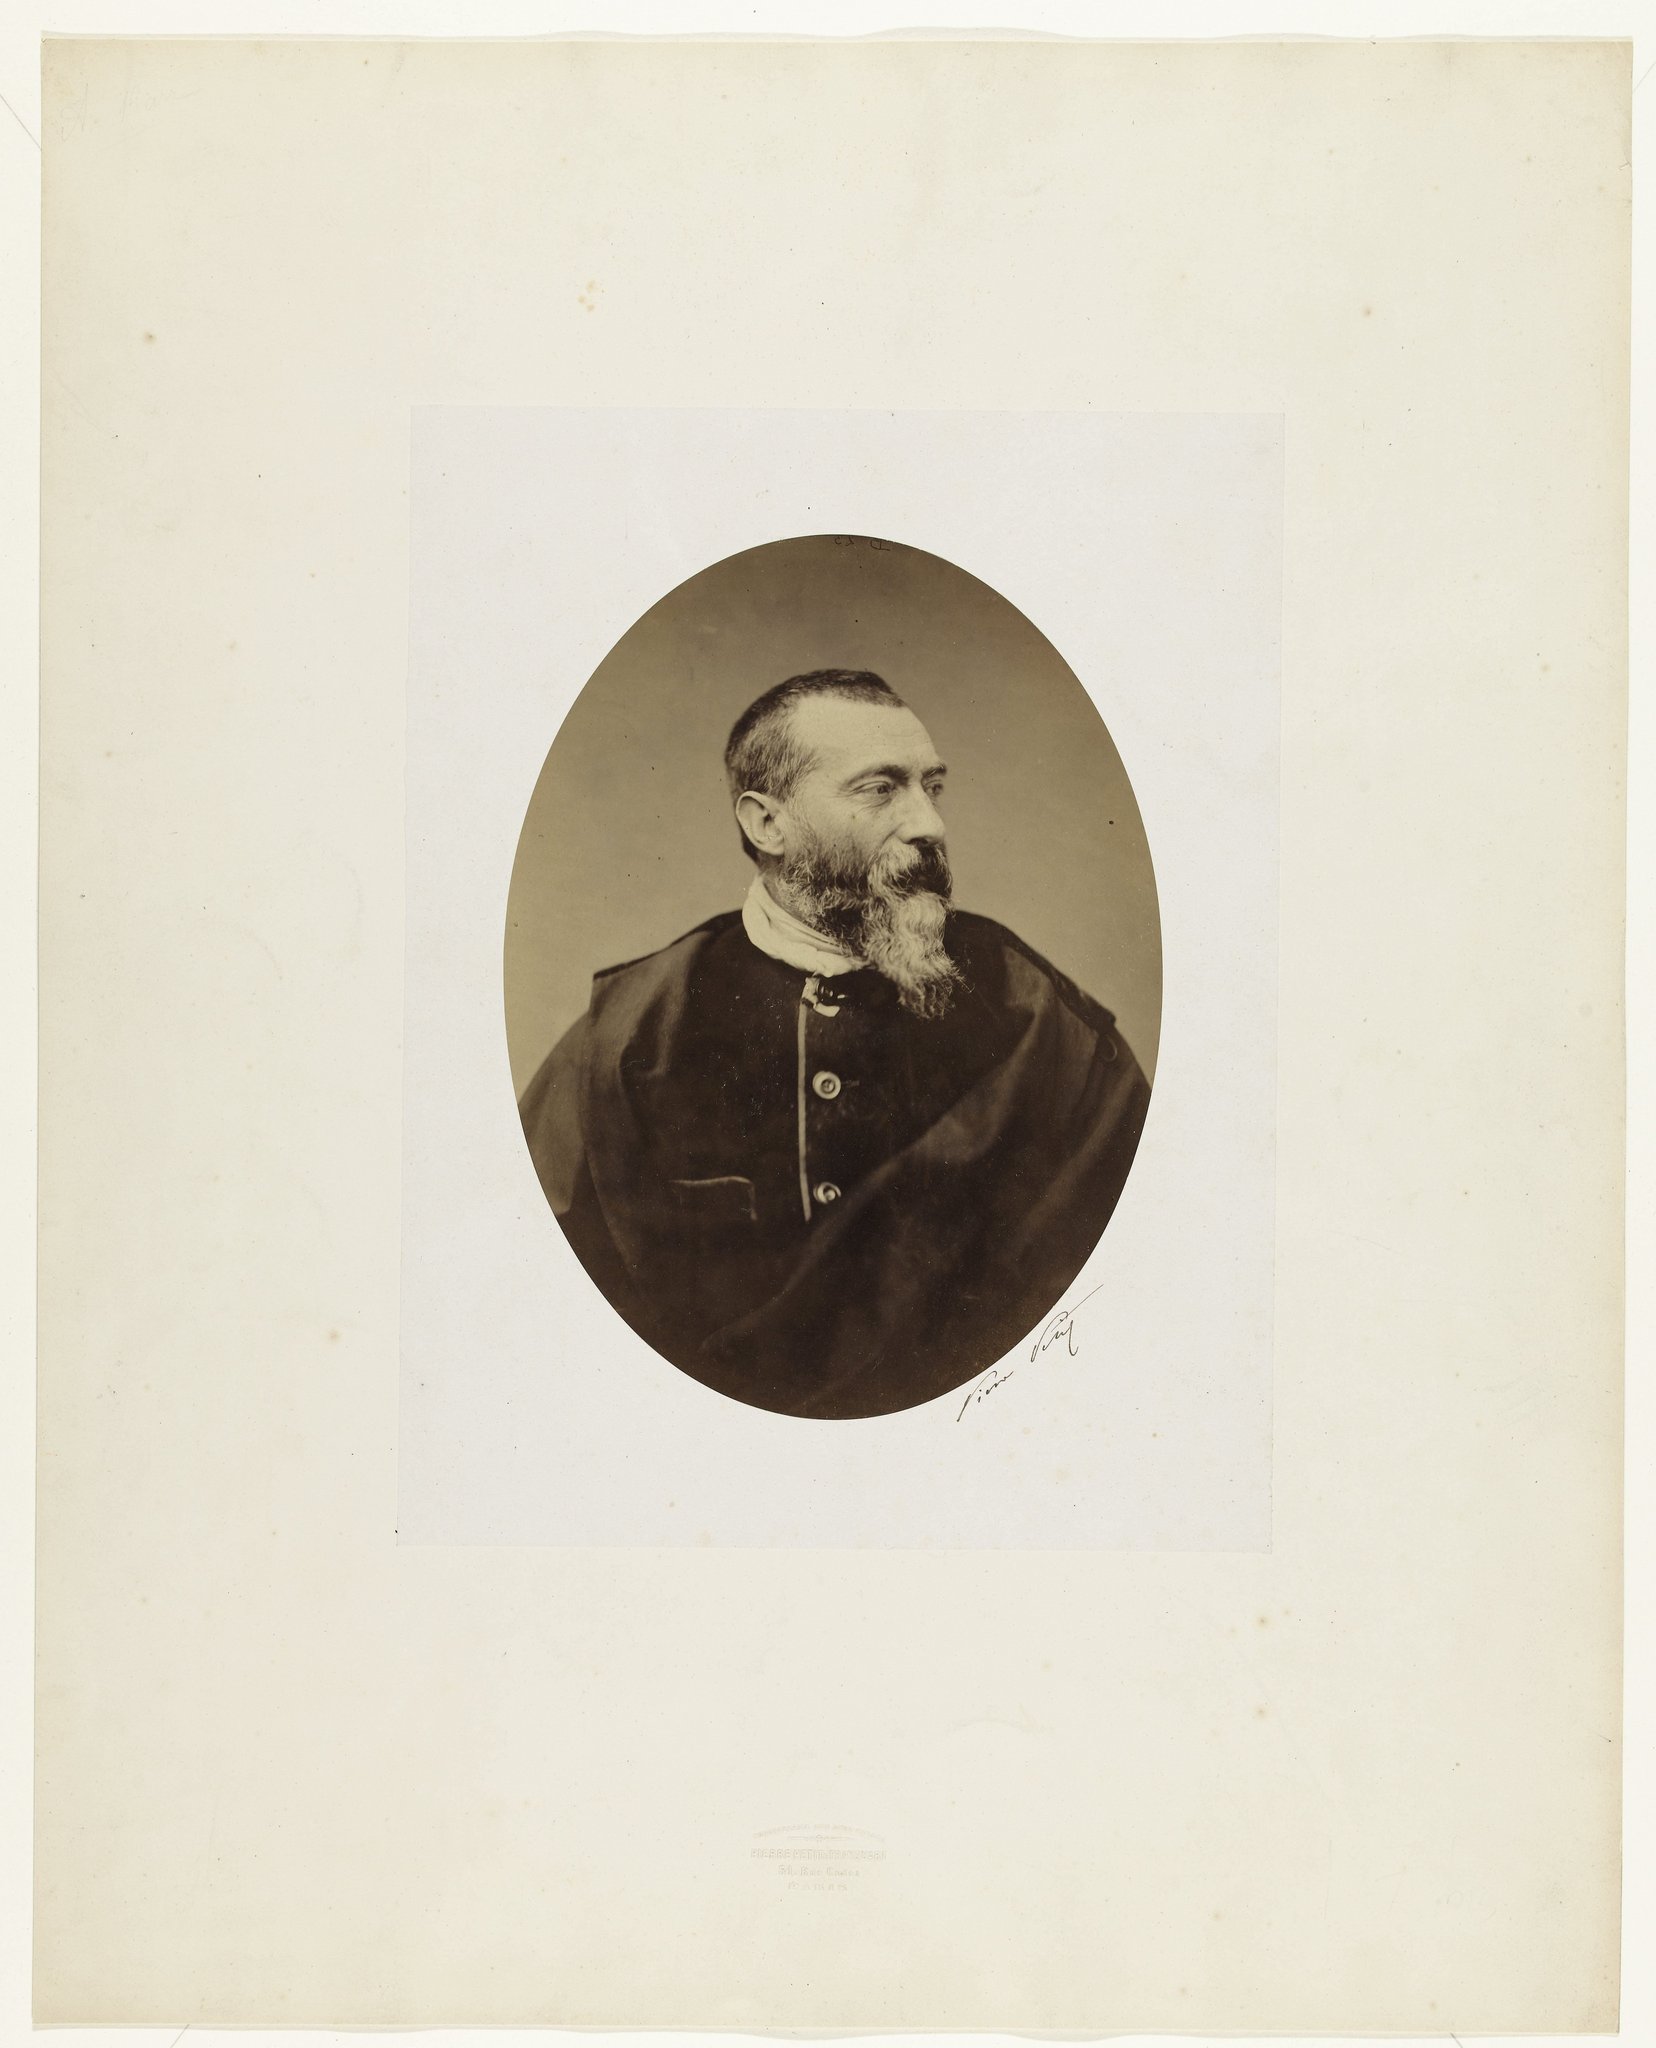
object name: photograph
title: Portret van de schrijver Alphonse Karr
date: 1859-1861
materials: cardboard, photographic support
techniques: albumen print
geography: paris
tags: portrait of a writer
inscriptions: check stamp, signature: ‘Pierre Petit’